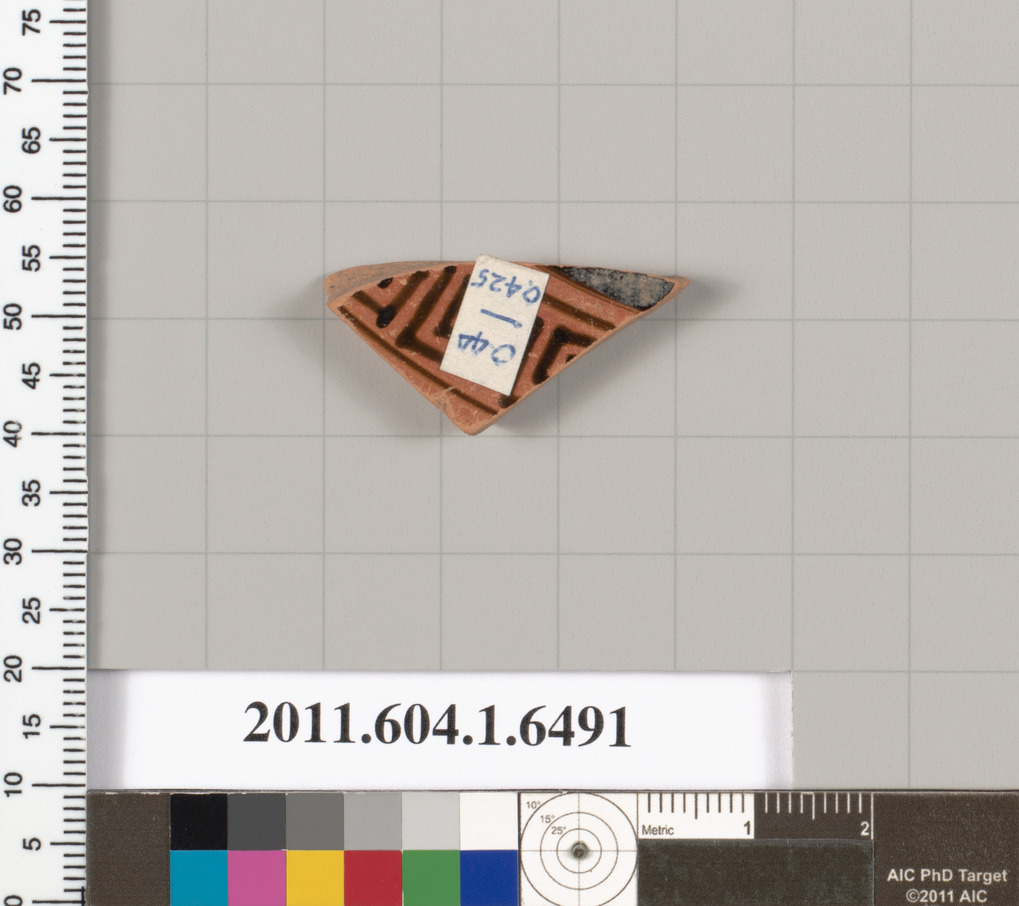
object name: kylix fragment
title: Terracotta fragment of a kylix (drinking cup)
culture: greek, attic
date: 490-480 BCE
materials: terracotta